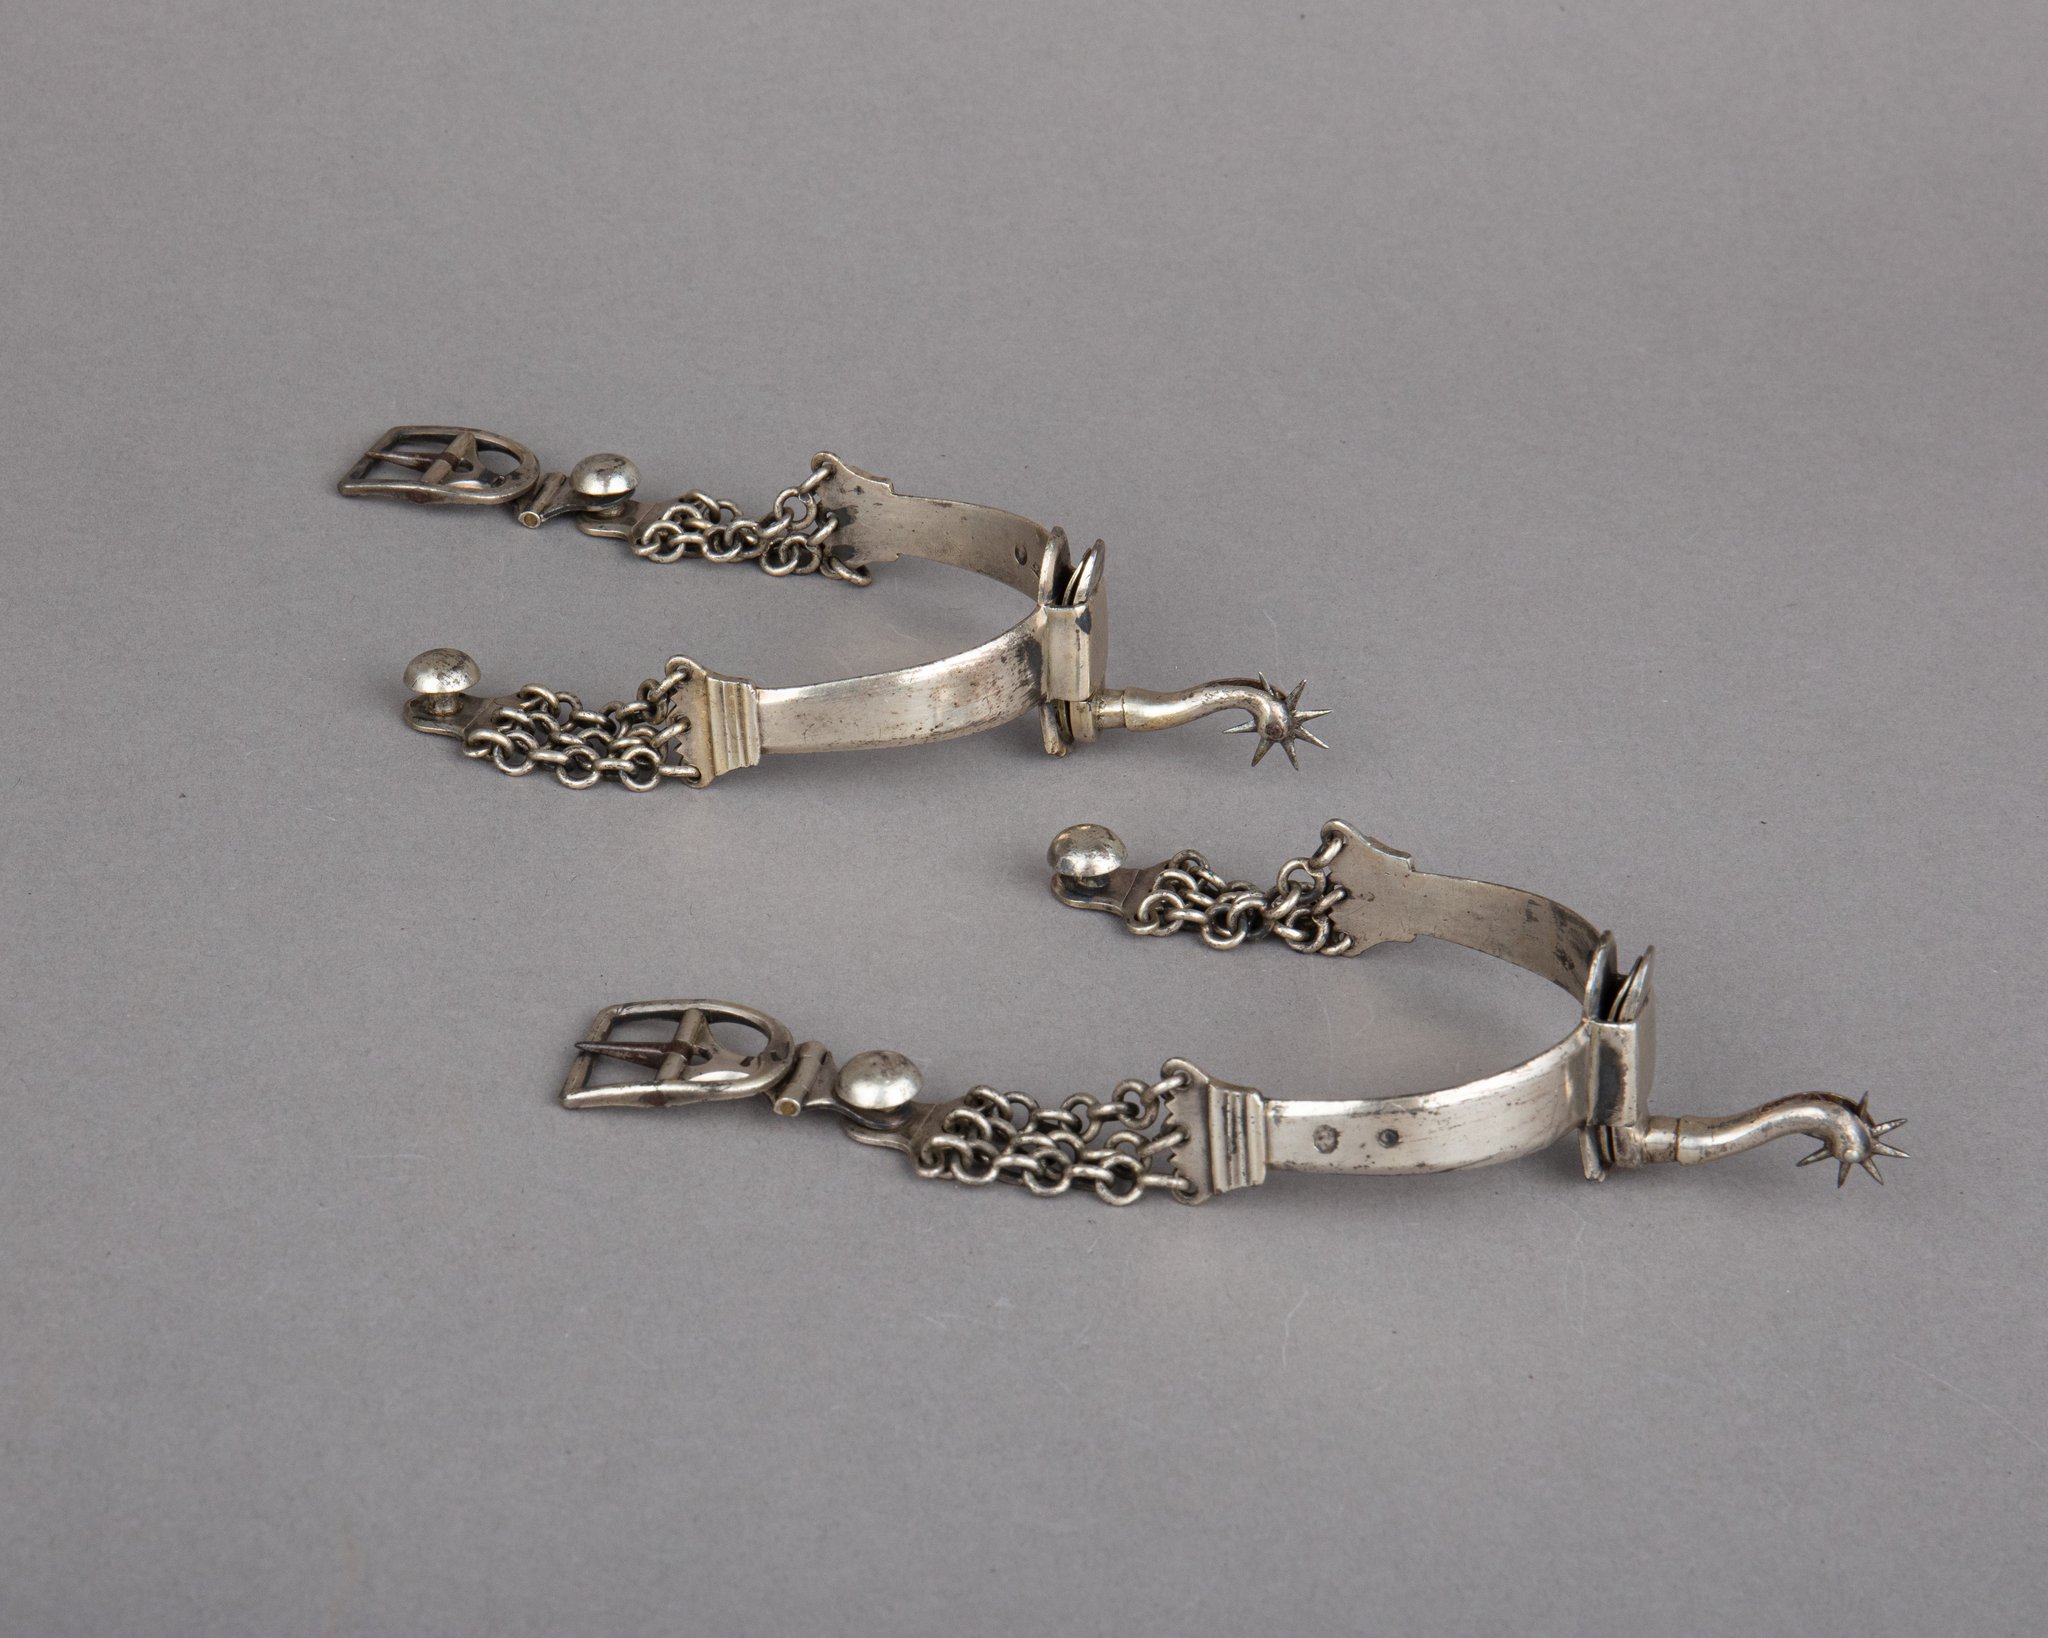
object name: spur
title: Pair of Rowel Spurs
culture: french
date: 1798-1809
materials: iron, silver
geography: france